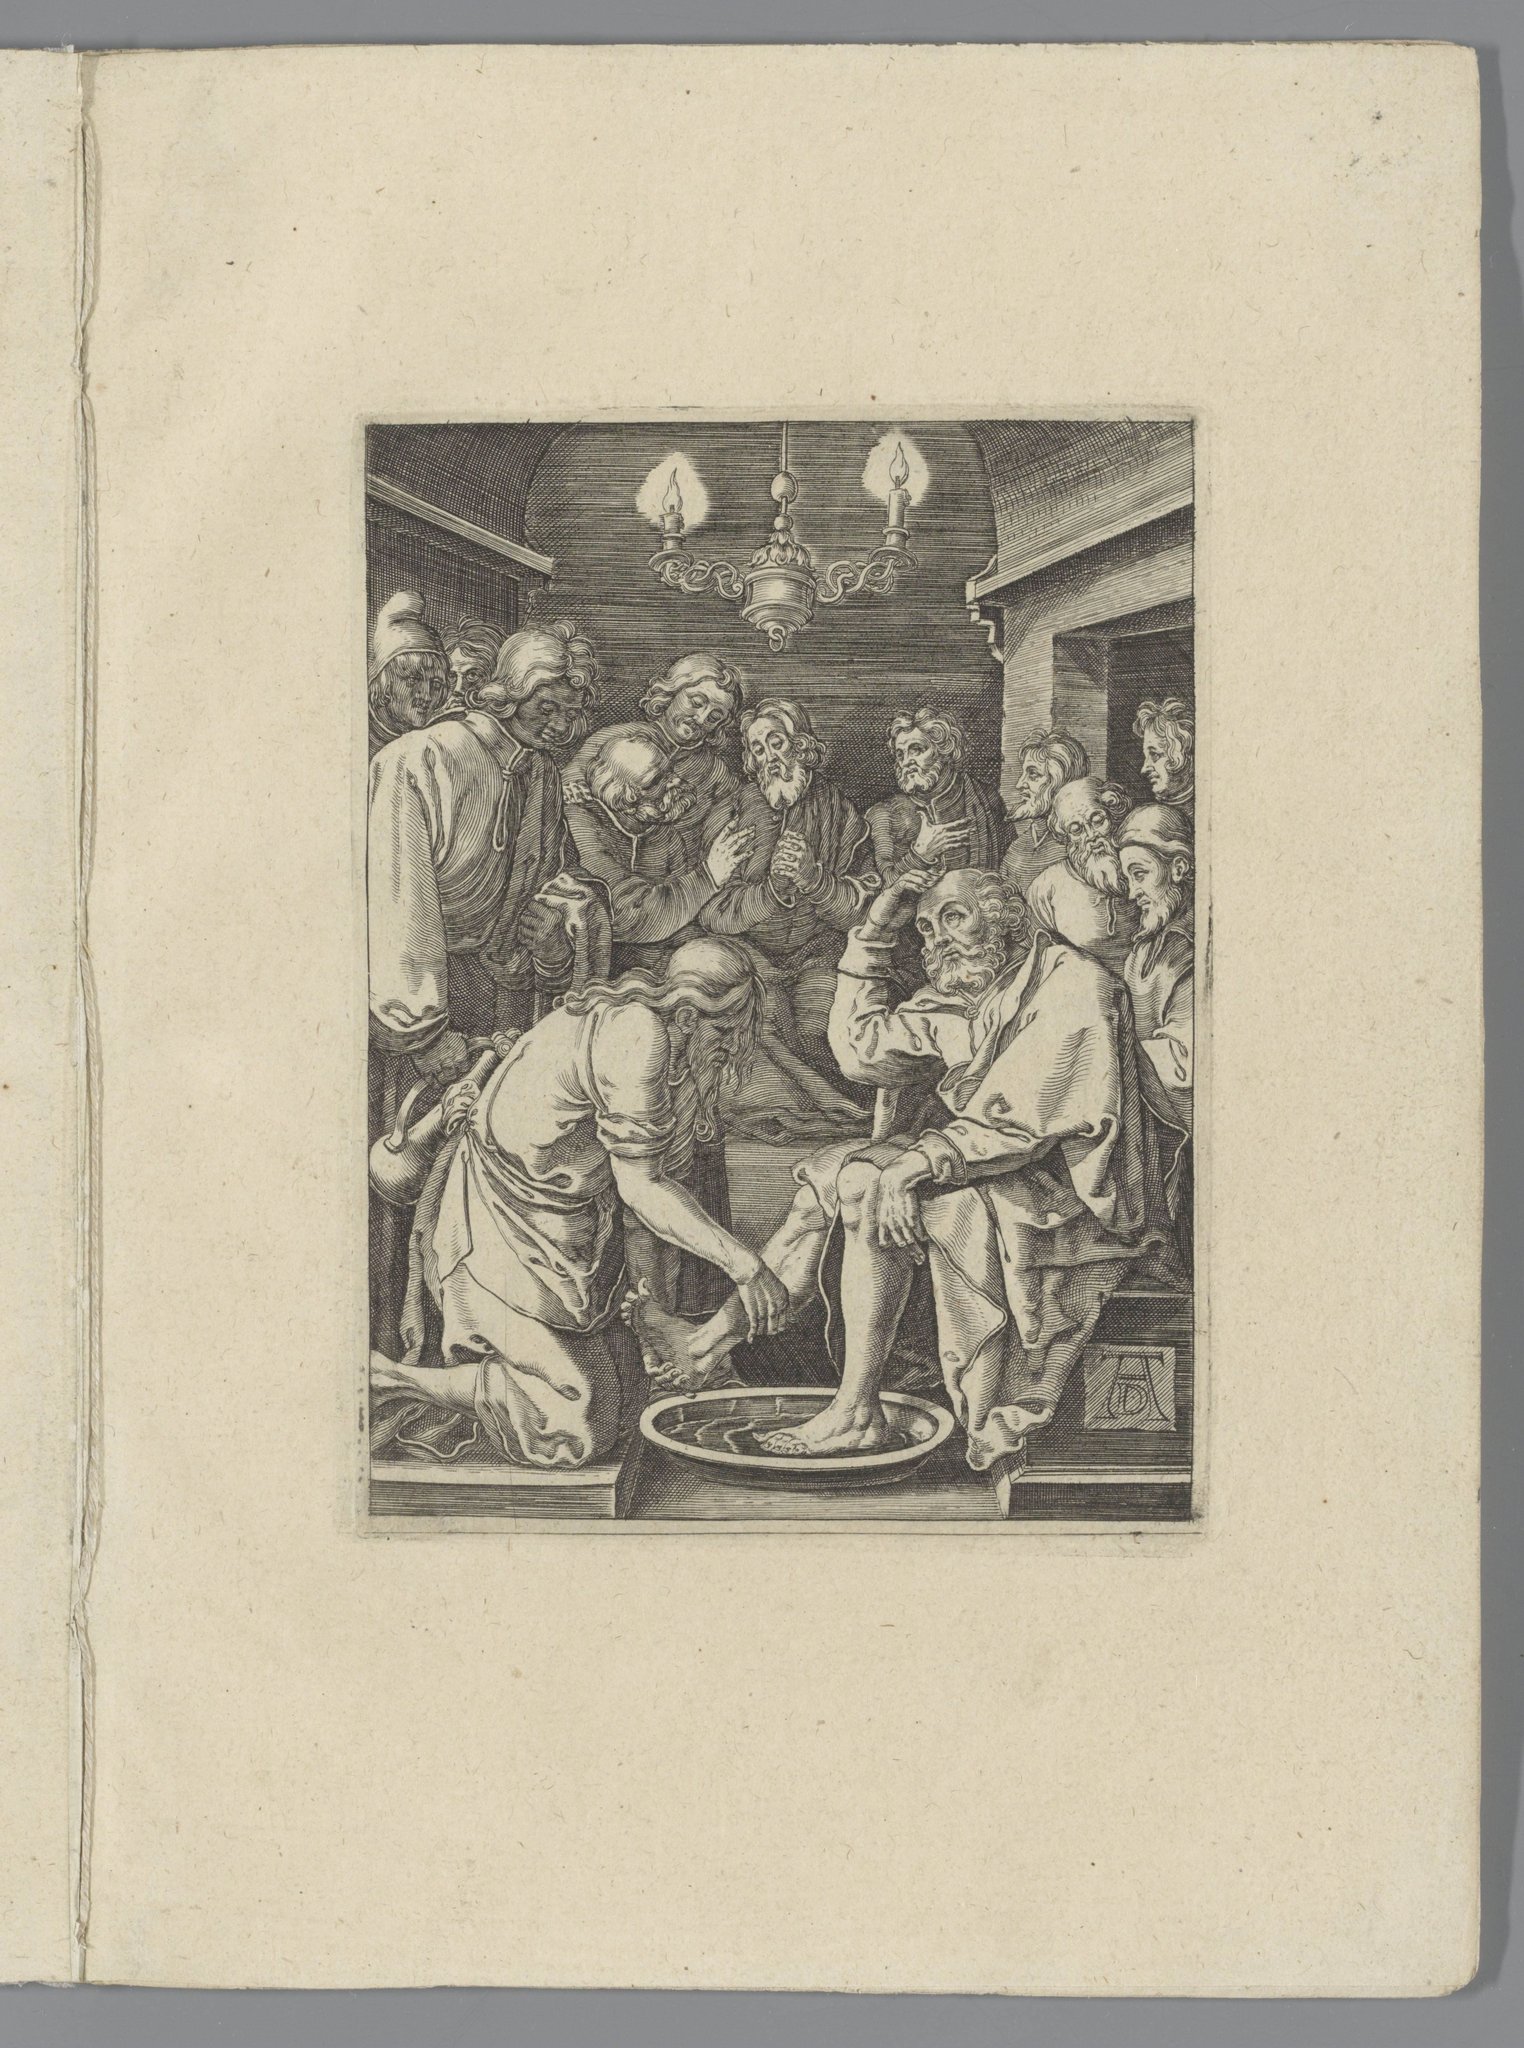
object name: album leaf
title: Passio Christi Ab Alberto Durer Nurenburgensi Effigiata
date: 1610-1620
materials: paper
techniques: engraving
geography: the hague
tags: christ washes peter's feet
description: Christus zit geknield voor de apostel Petrus en wast zijn voeten. Petrus wijst op zijn hoofd. De andere apostelen staan rondom hen in het vertrek. Prent maakt deel uit van een album.